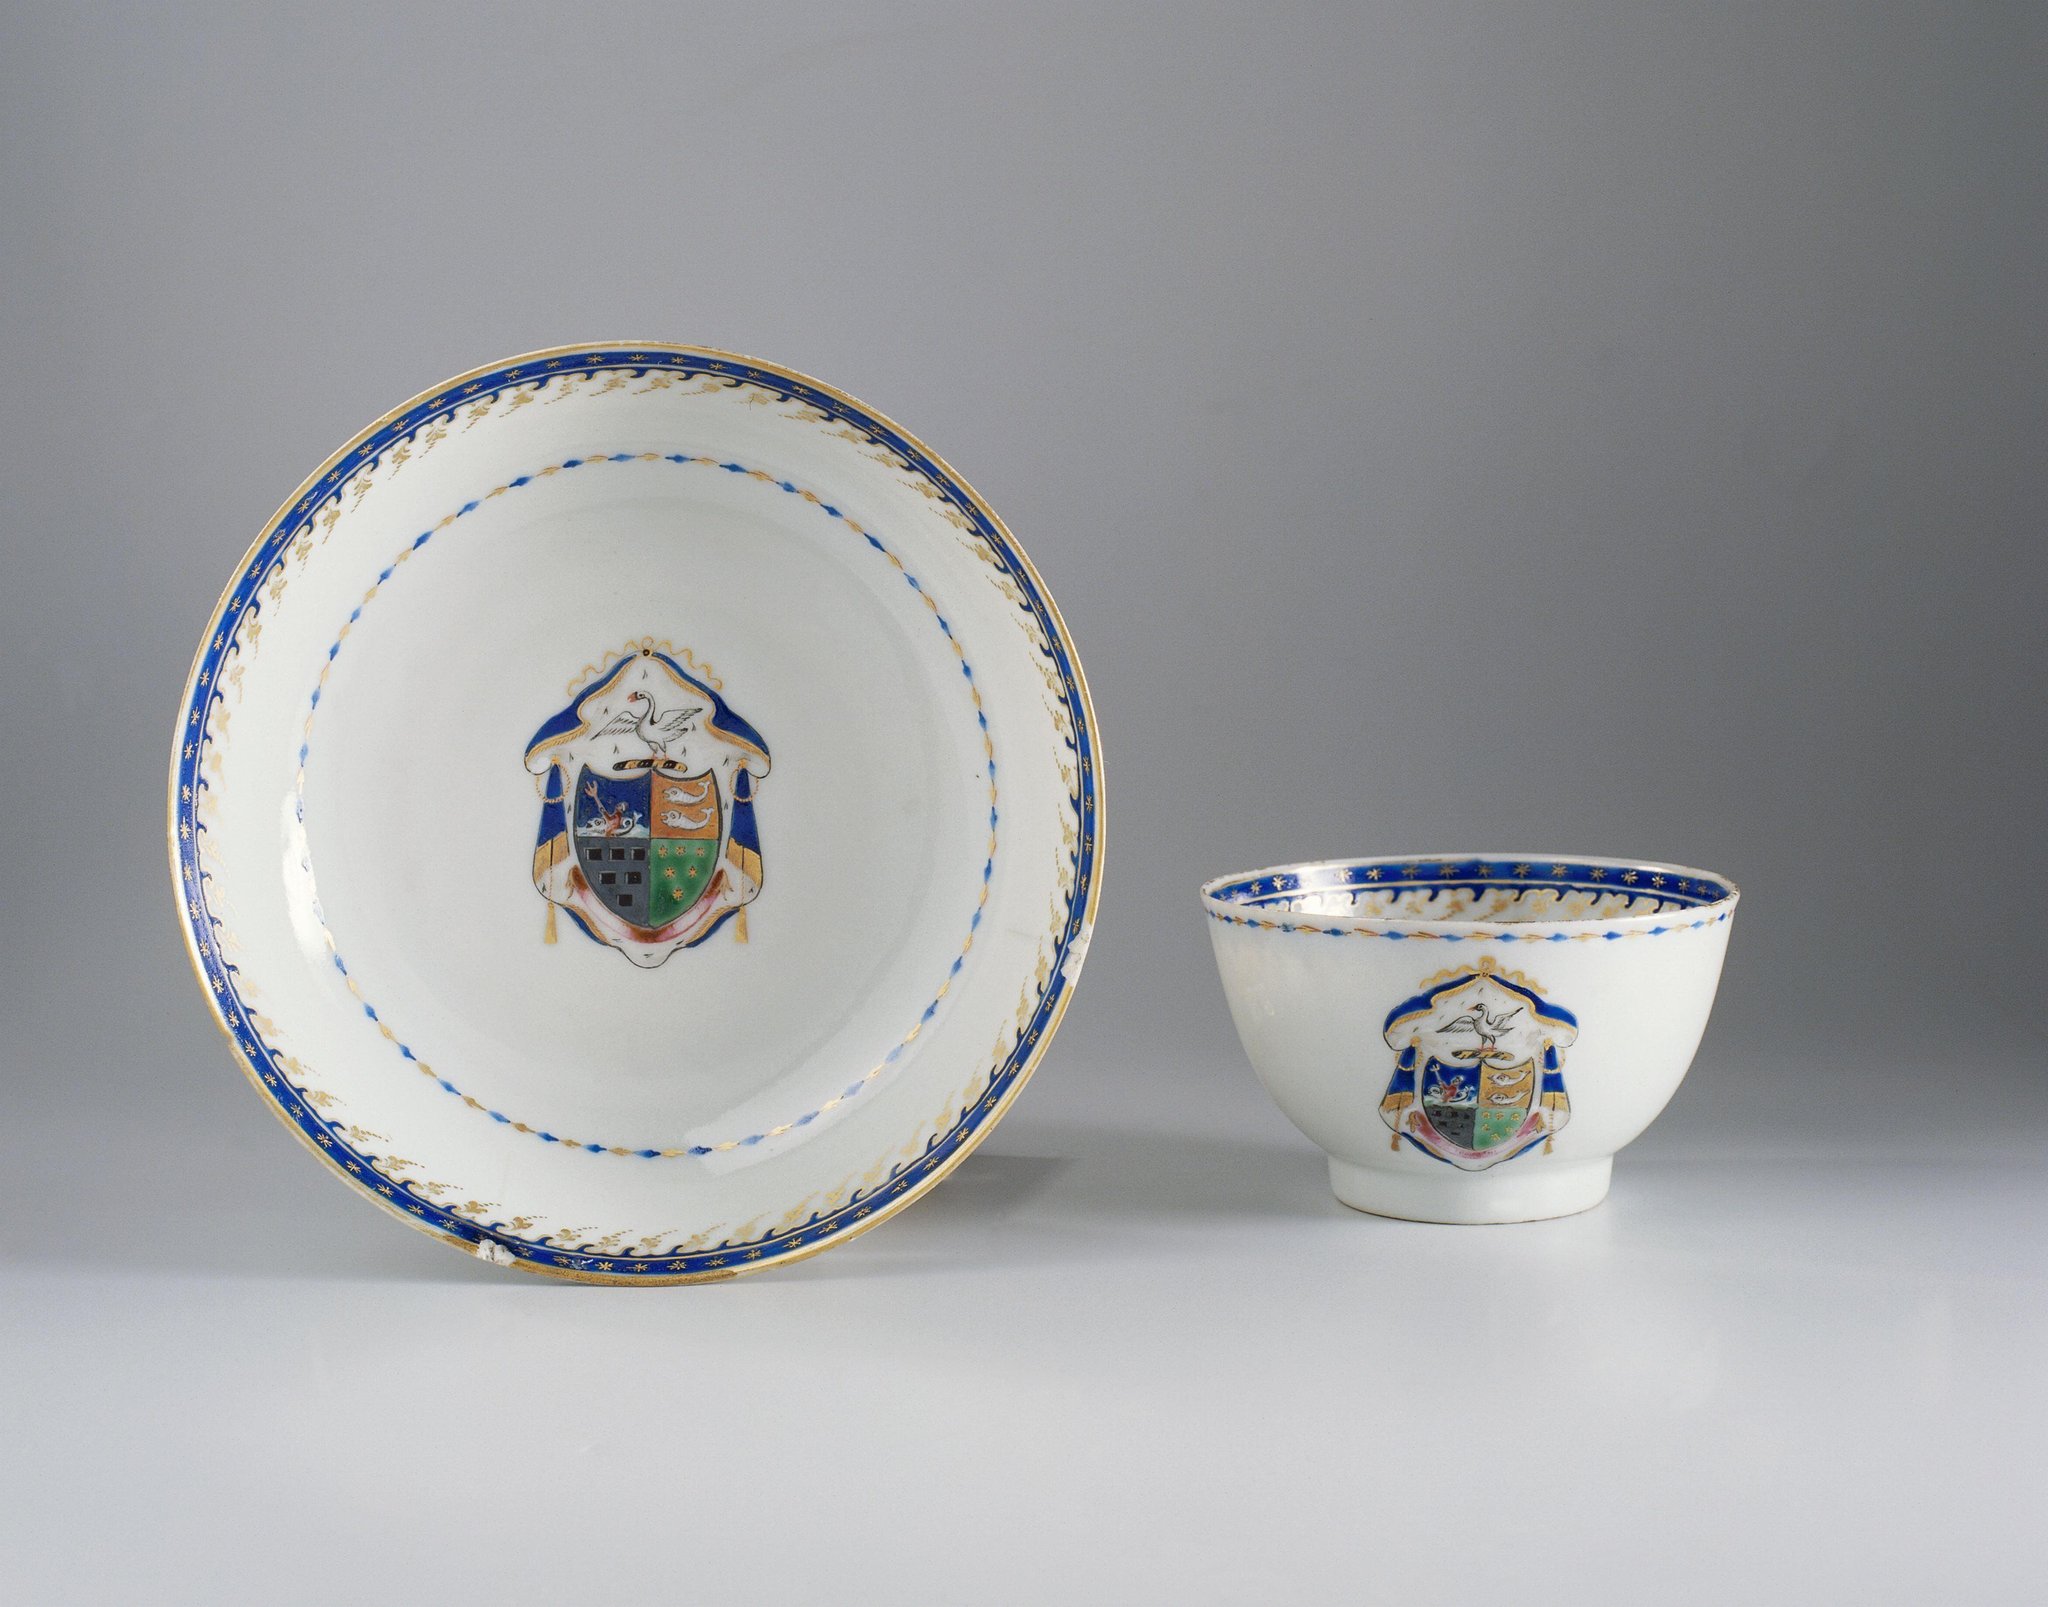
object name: cup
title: Cup with the arms of the Nolthenius family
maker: Anonymous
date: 1787-1790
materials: glaze, gold, paint, porcelain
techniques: firing, gilding, turning, vitrification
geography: china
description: Kop en schotel van porselein. Versierd met een rand in blauw en goud en het veelkleurig familiewapen Nolthenius met helmteken: zwaan op wrong.